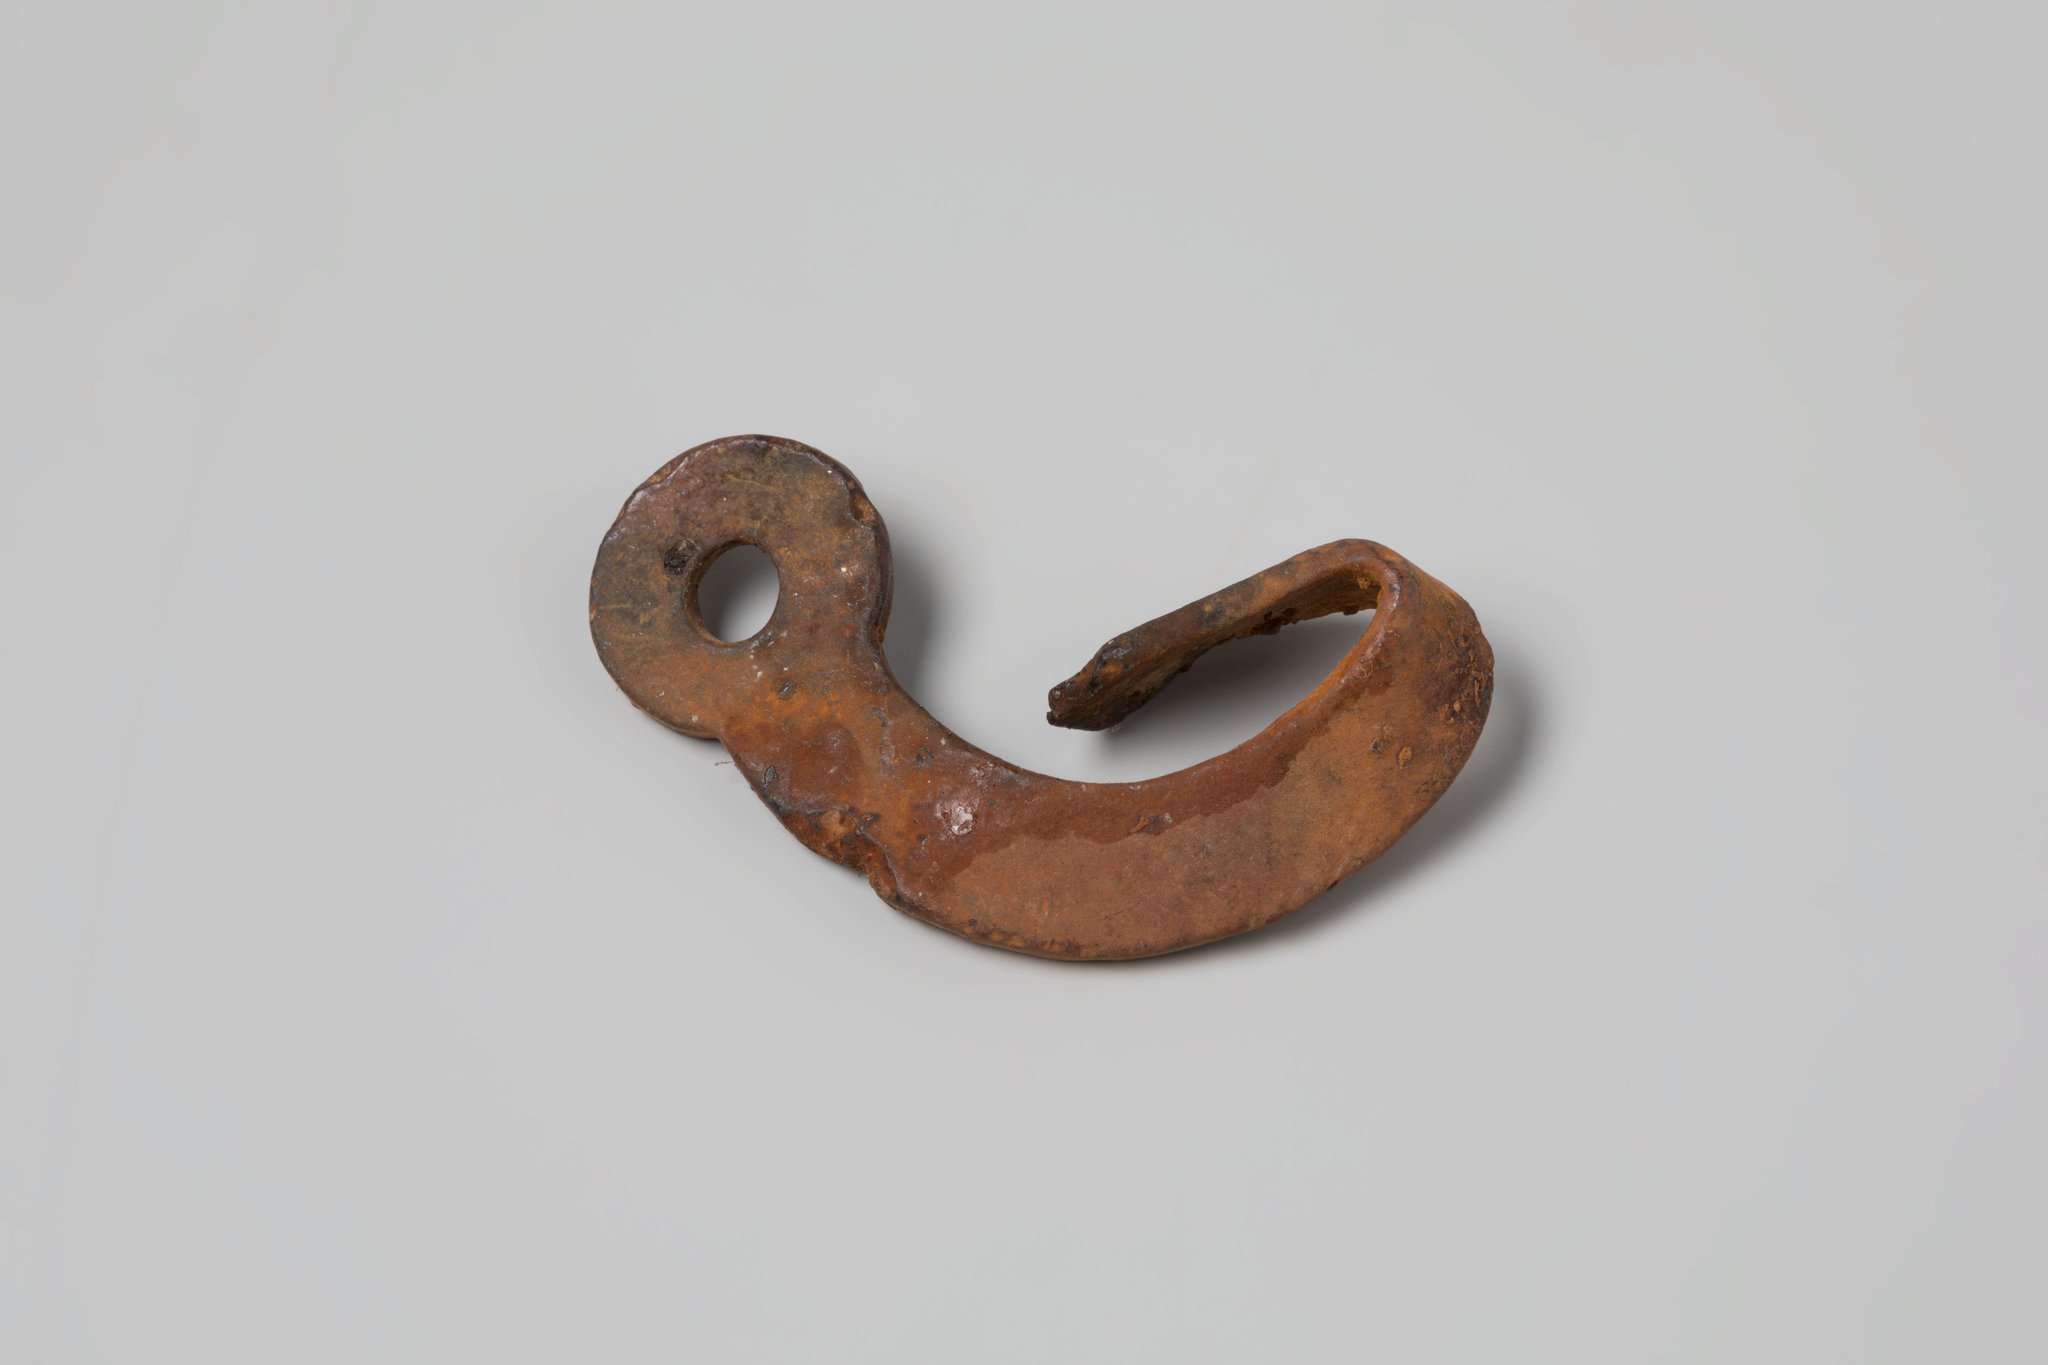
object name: divider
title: Fragment steekpasser uit het wrak van de Oost-Indiëvaarder Hollandia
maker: Anonymous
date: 1700-1743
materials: copper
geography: netherlands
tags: verenigde oostindische compagnie, hollandia (schip), annet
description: Divider; fragment, semicircular ring, id. NG 1980-27H1669, twisted.